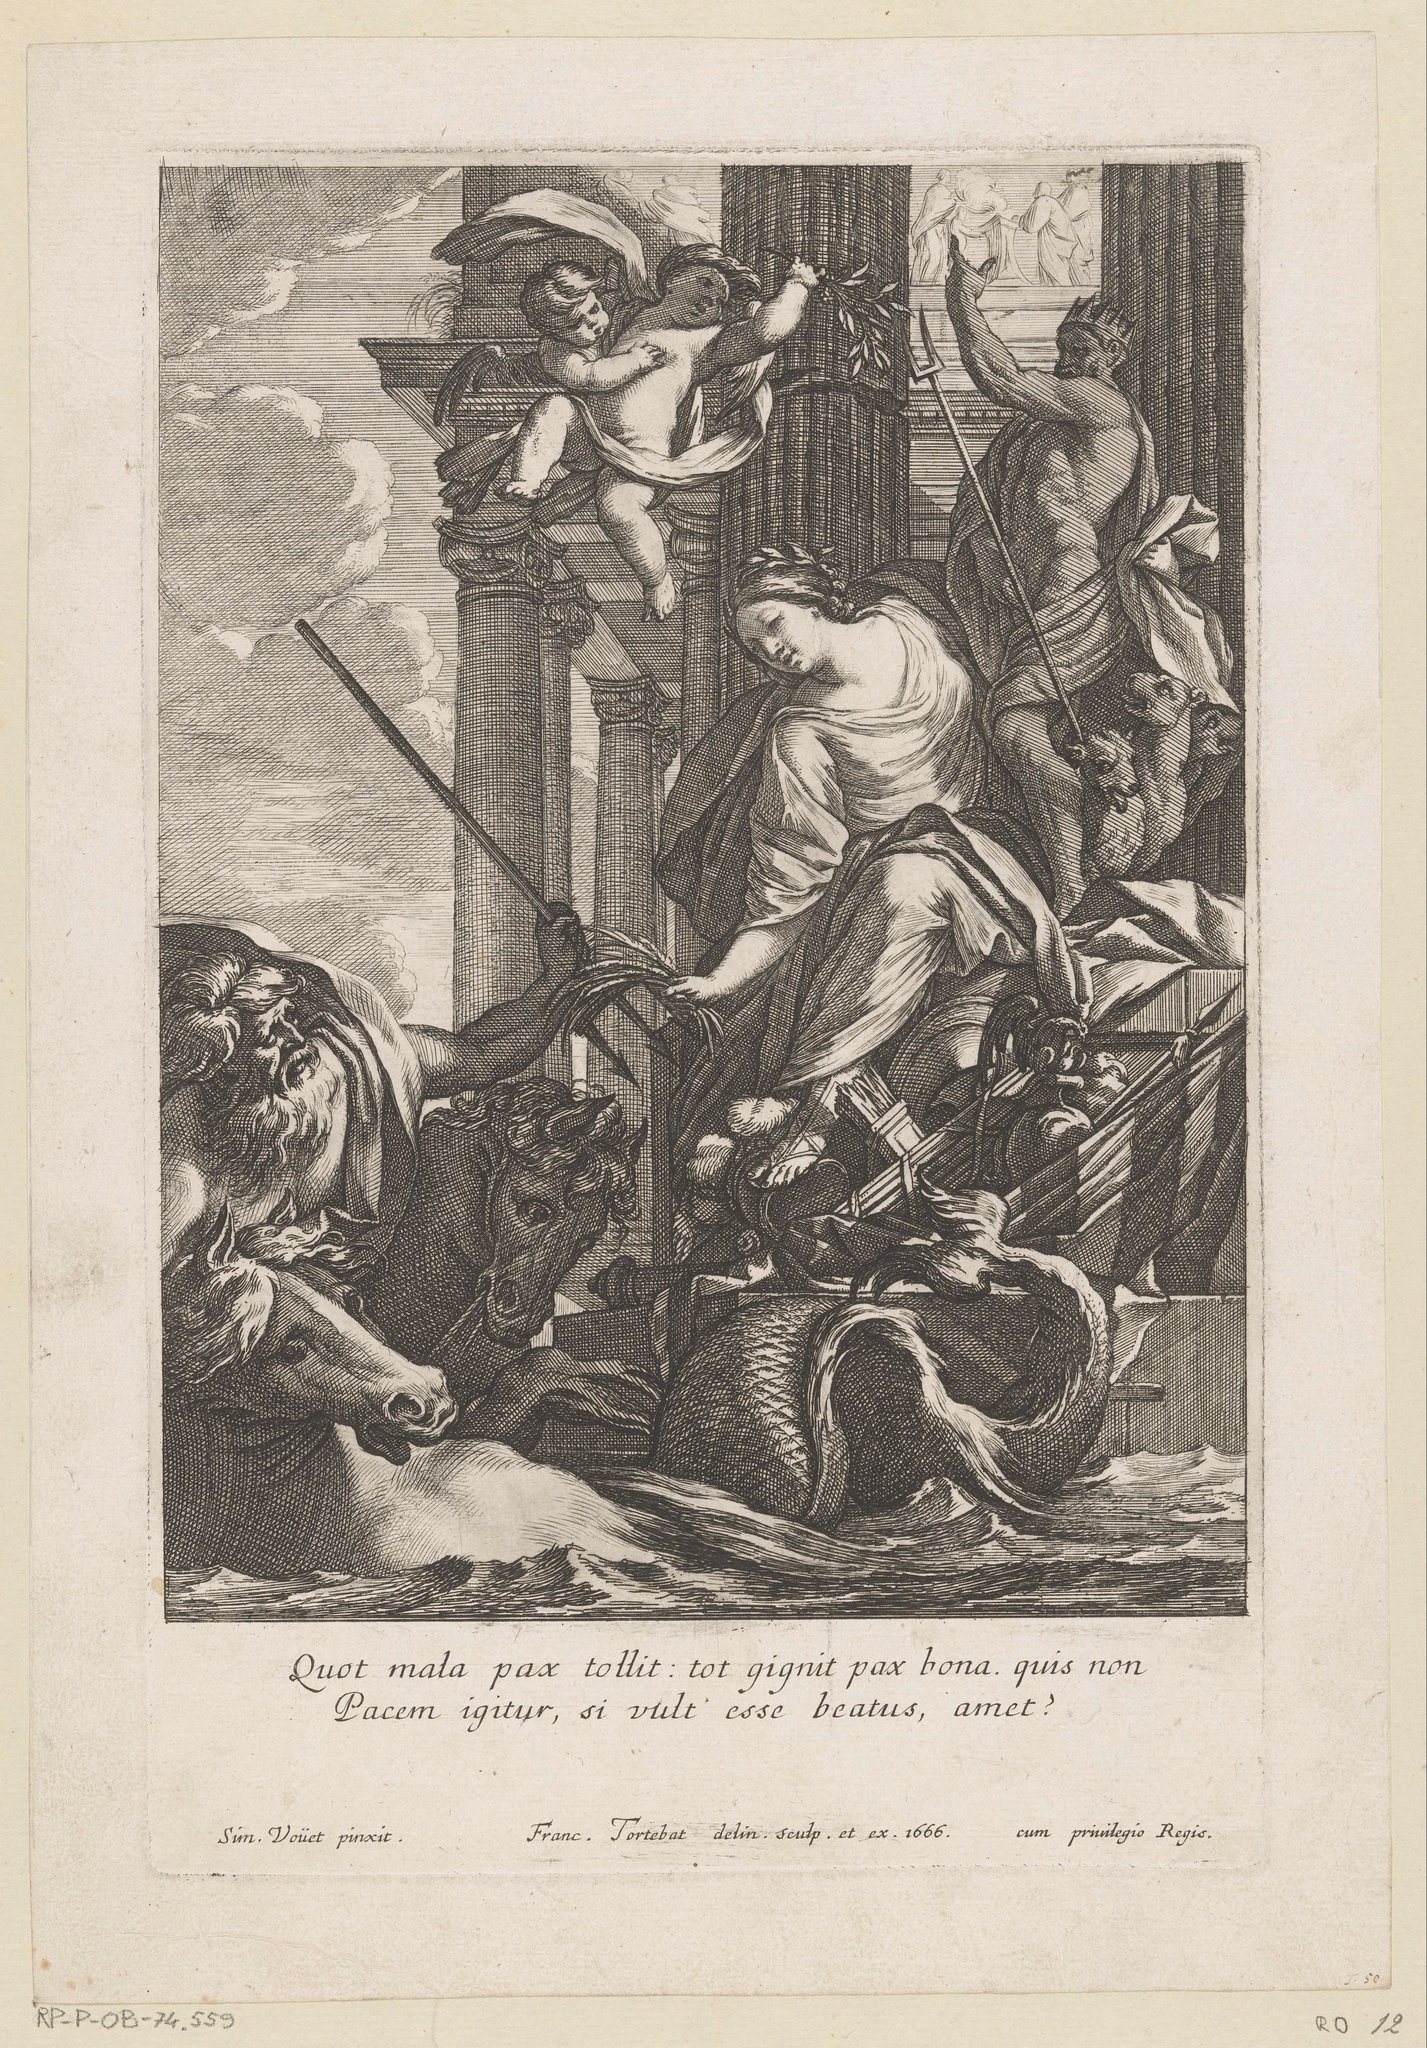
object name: print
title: Allegorie op de Vrede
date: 1666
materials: paper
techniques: engraving, etching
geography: paris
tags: figure representing a virtue vs. a vice, (story of) neptune (poseidon), gods of the waters: neptune and his environment, sculpture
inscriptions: collector's mark: Lugt 240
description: Vrede gezeten op wapens en helmen overhandigt koren aan Neptunus; een tempel en een beeld van Pluto achter haar